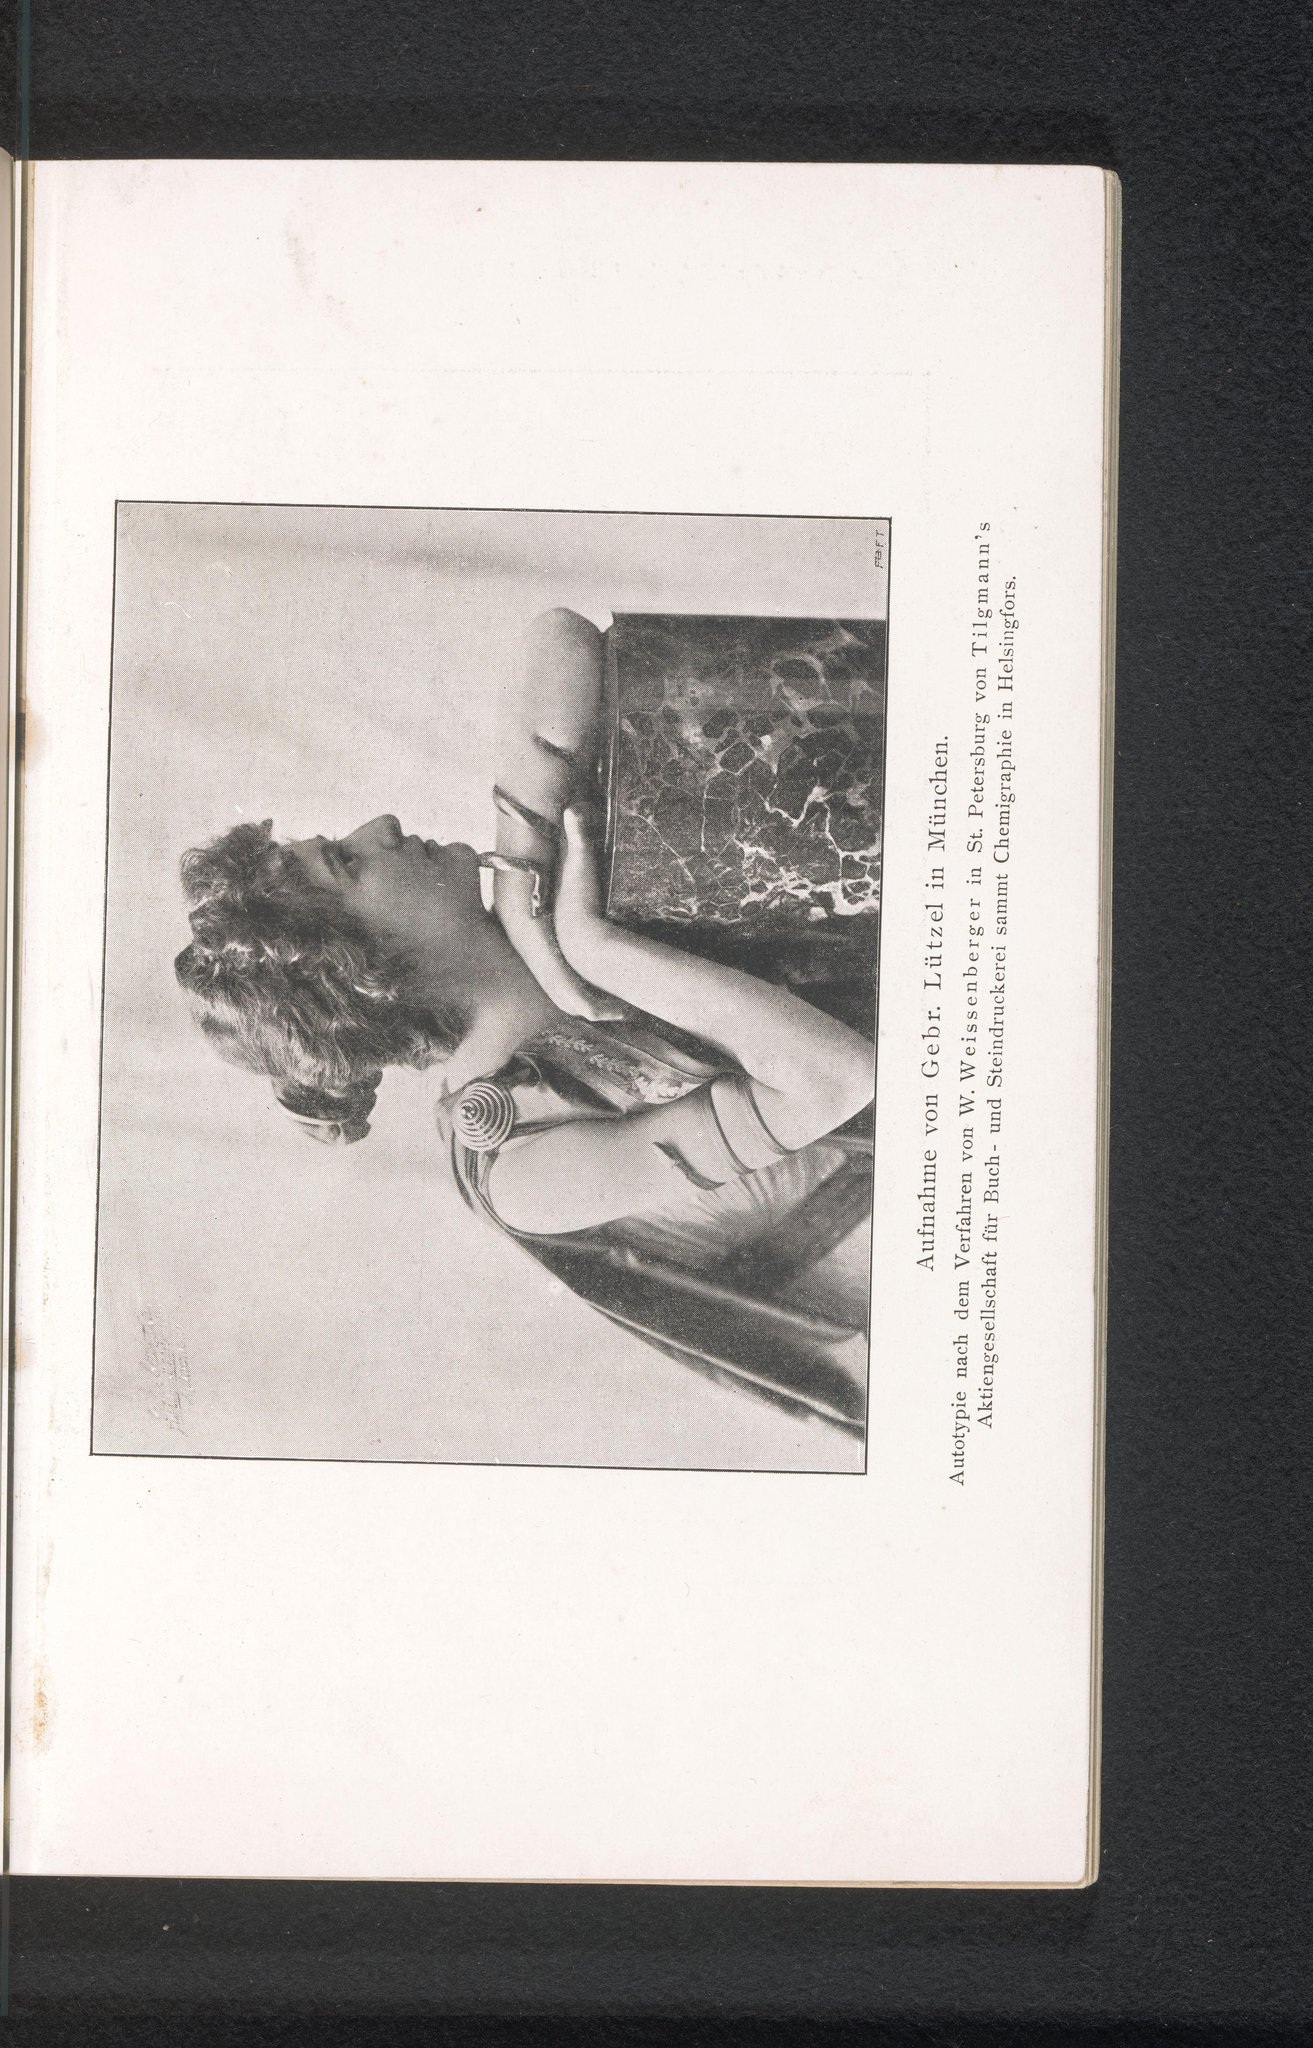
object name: photomechanical print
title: Portret van een onbekende vrouw in kostuum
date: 1894-1899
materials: paper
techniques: autotype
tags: adult woman, historical persons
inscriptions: inscription: ‘Autotypie nach dem Verfahren von W. Weissenberger in St. Petersburg von Tilgmann's/ Aktiengeschaft für Buch- und Steindruckerei/ sammt Chemiegraphie in Helsingfors.’